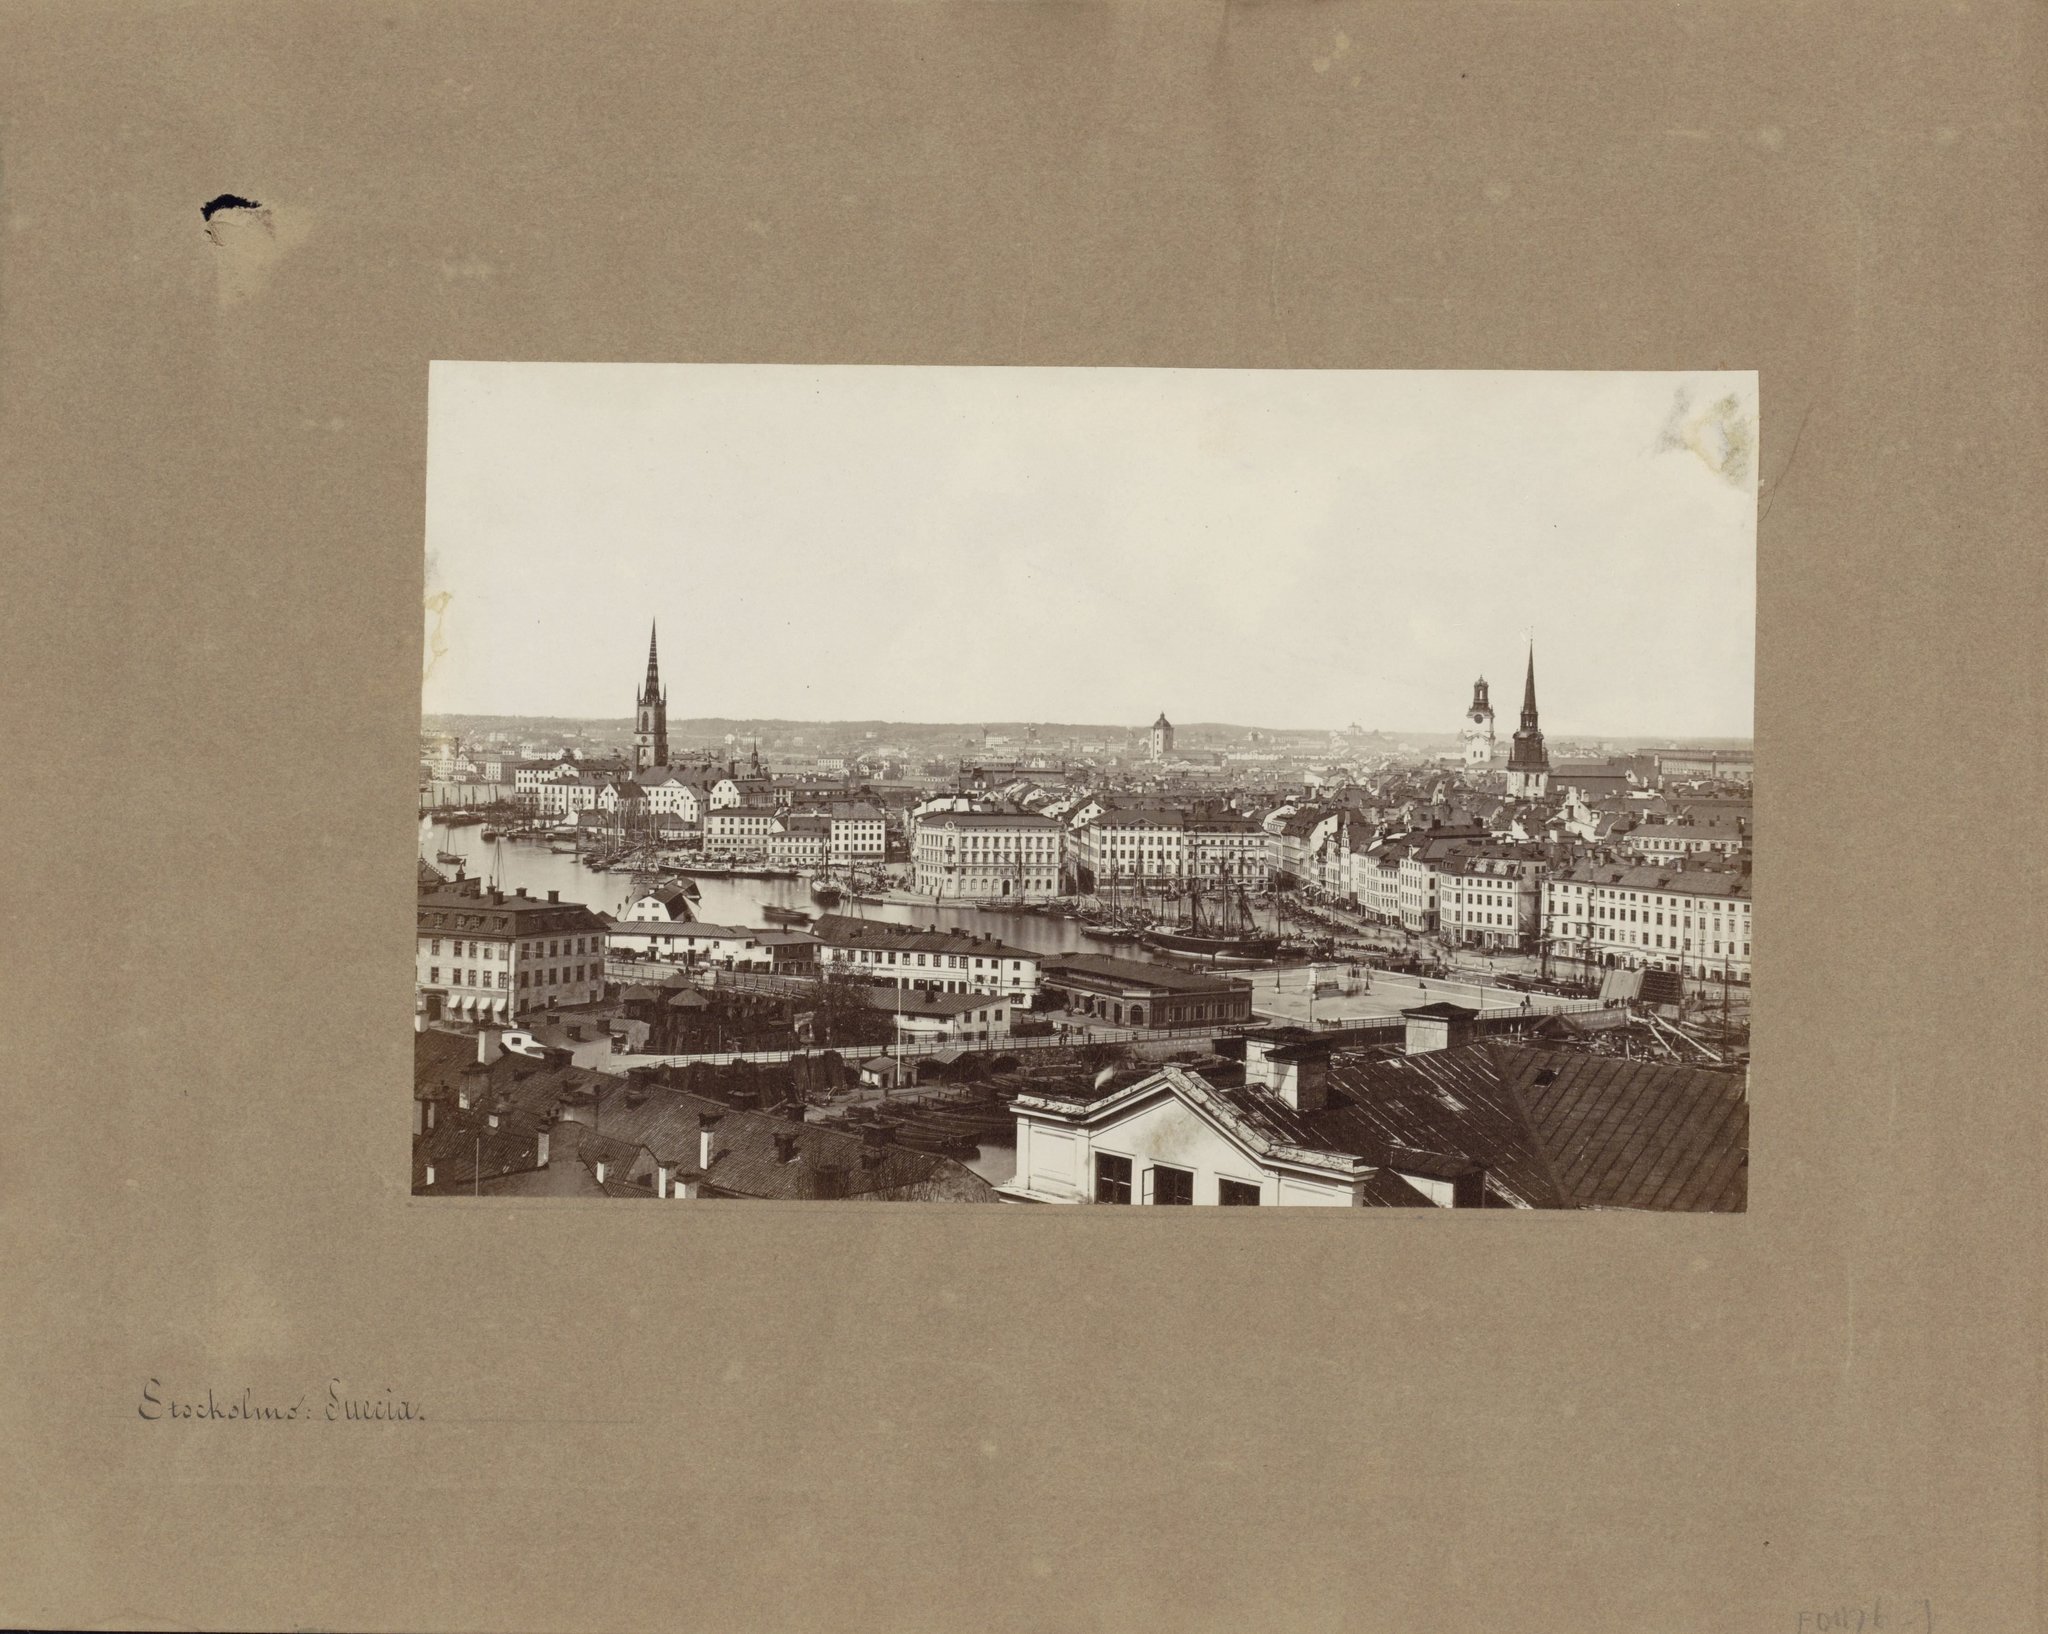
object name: photograph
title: Stockolms: Suecia.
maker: Anonymous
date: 1850-1876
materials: photographic support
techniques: albumen print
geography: stockholm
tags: harbour, tower, clock tower ~ monumental adornment, city-view in general; 'veduta', travelling; tourism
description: Onderdeel van Reisalbum met foto's en tekeningen van Manuel Mayo 1876.